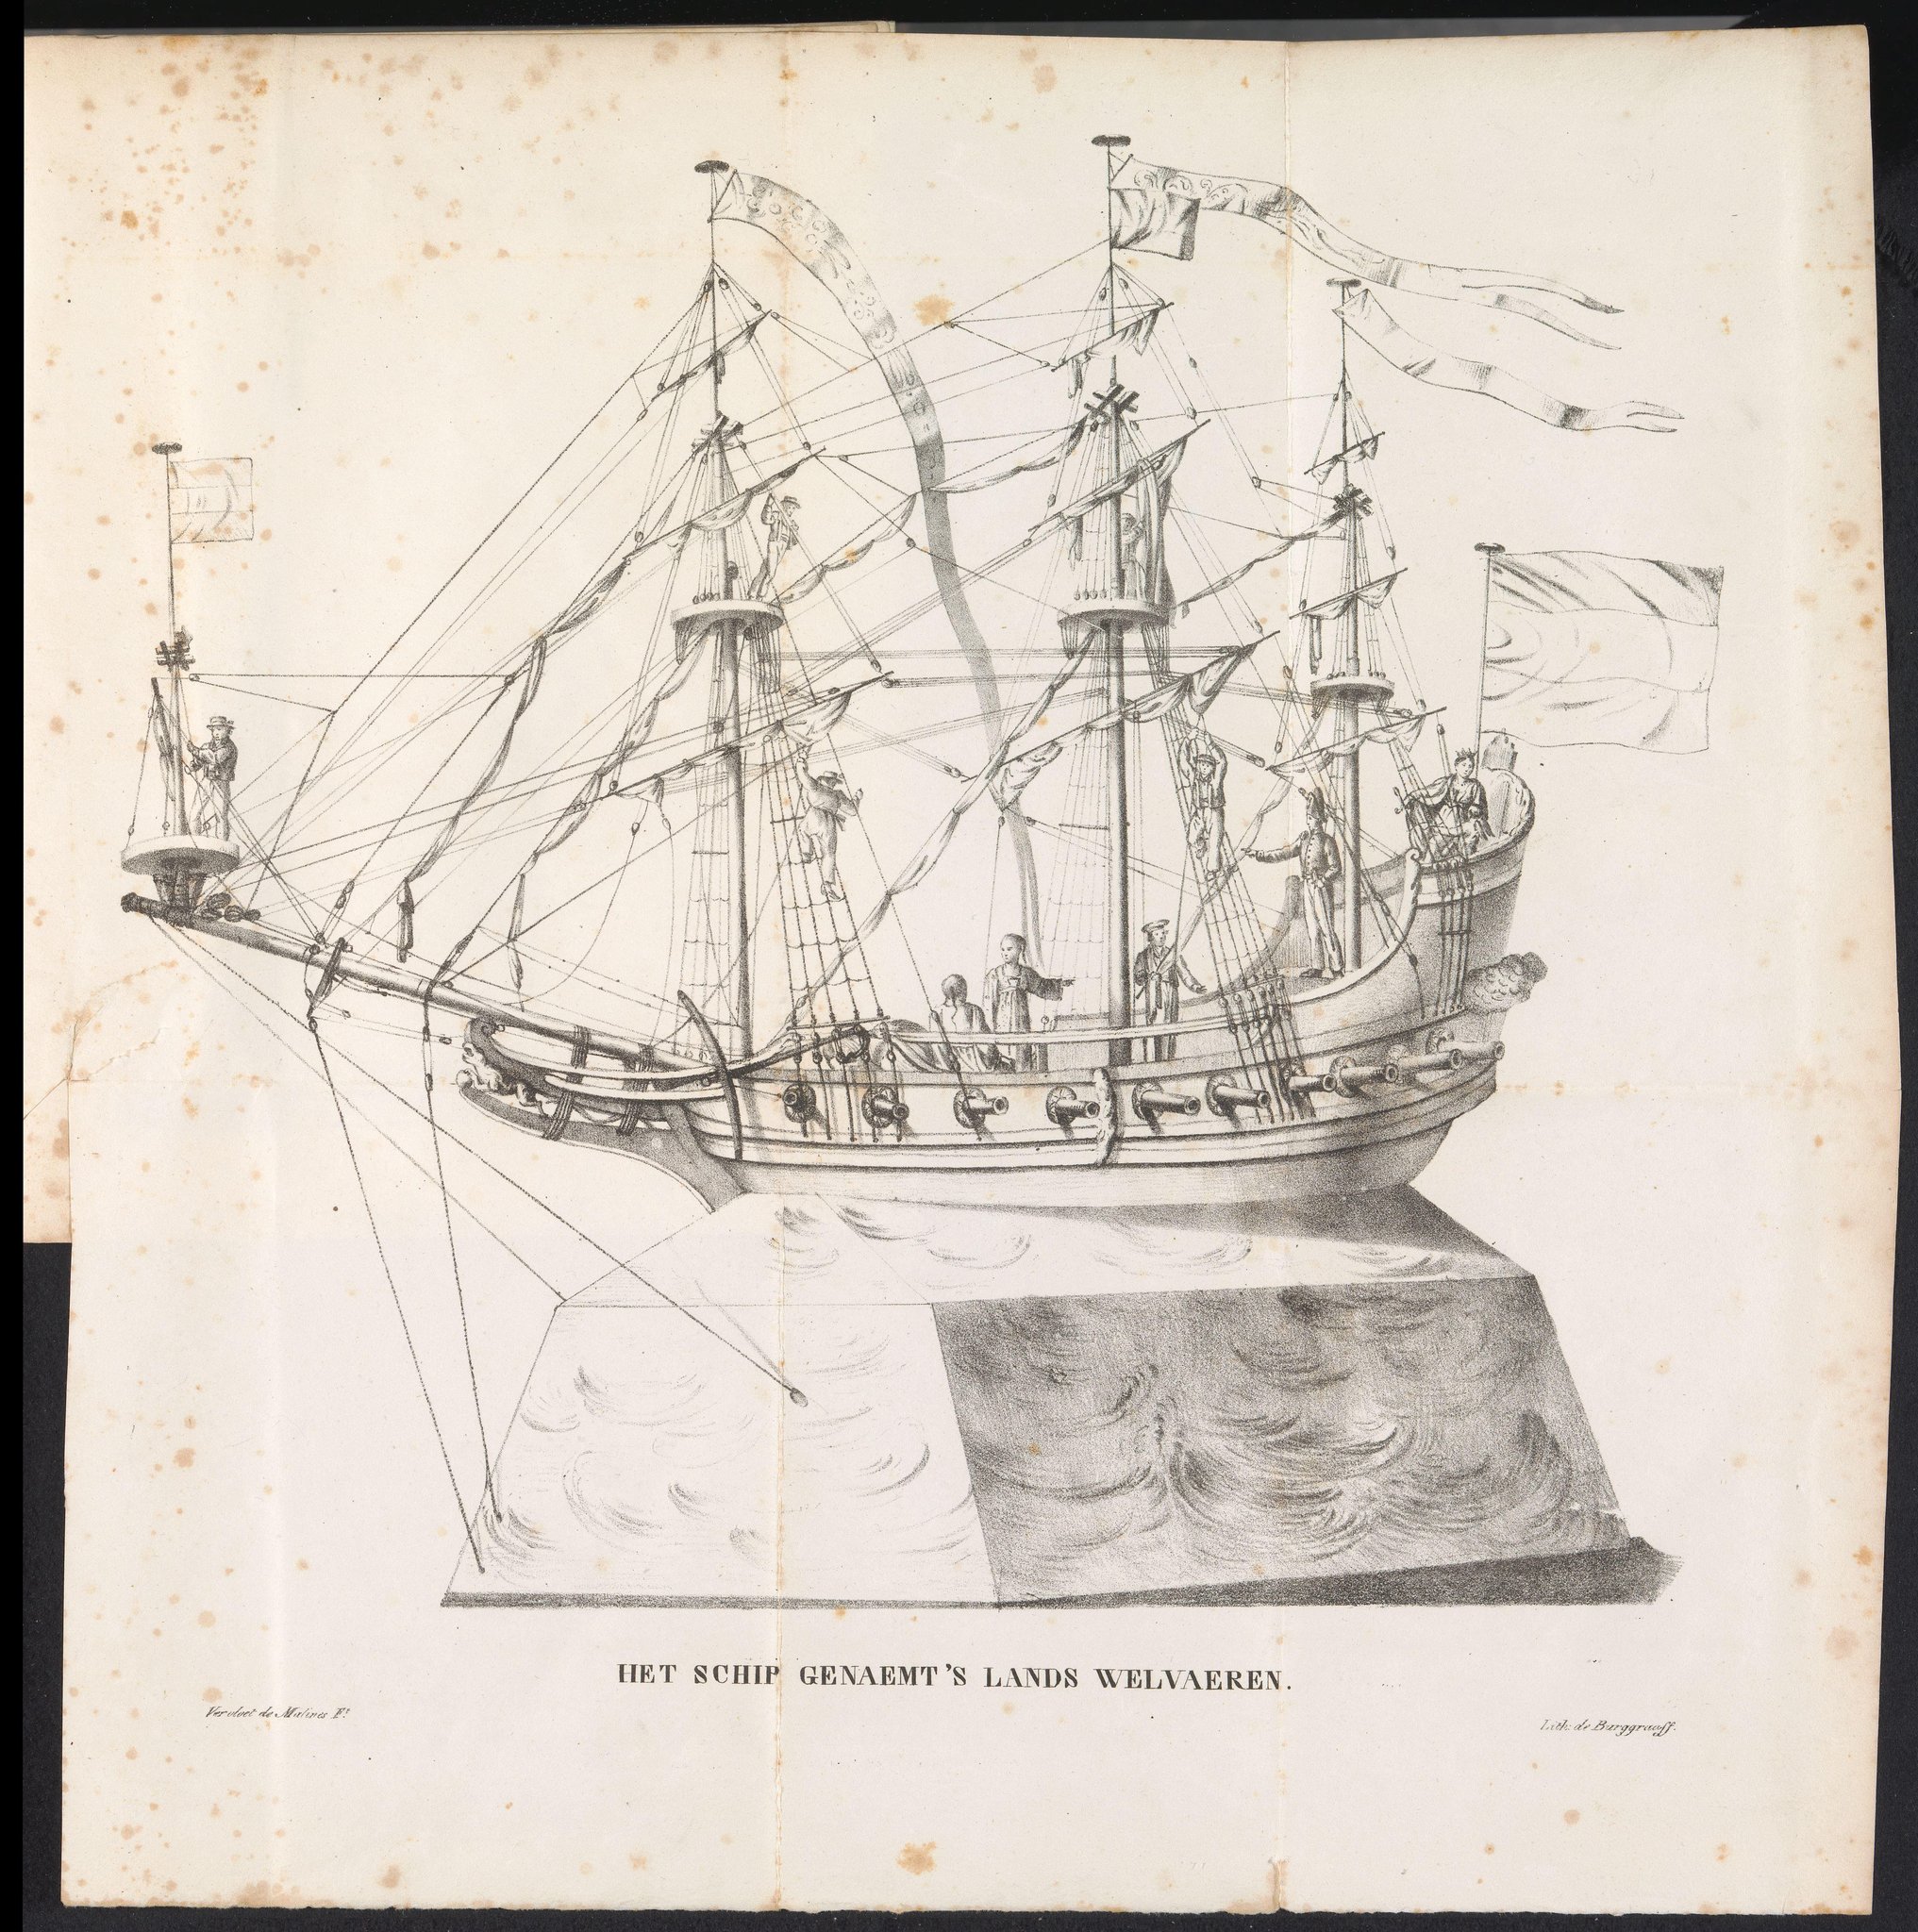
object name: print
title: Schip als praalwagen in de optocht voor de Heilige Rombout, 1825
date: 1825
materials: paper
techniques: lithograph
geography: brussels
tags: ships (in general) (+ propulsion of vehicle, ship, etc. by wind), rejoicing on special occasions (+ parade, pageant, cavalcade ~ festive activities), the hermit, martyr, and possibly former bishop of dublin, rum(b)old (rombaut) of malines; possible attributes: axe, hoe - post-mortem occurrences ~ male saint, procession ~ christian religion, mechelen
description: Een driemaster genaamd 's Lands Welvaeren (Schip van Staat) als een praalwagen in de ommegang voor de Heilige Rombout. Op het schip de kapitein en matrozen, een heilige, een engel, een Amerikaan en twee Chinezen. De optocht werd gehouden op 28 juni, 5 en 12 juli 1825. Illustratie in een publicatie ter gelegenheid van de 1050-jarige viering in 1825 van de dood van de Heilige Rumoldus of Rombout, patroonheilige van de stad Mechelen, van wie werd gedacht dat hij in 775 was gestorven.